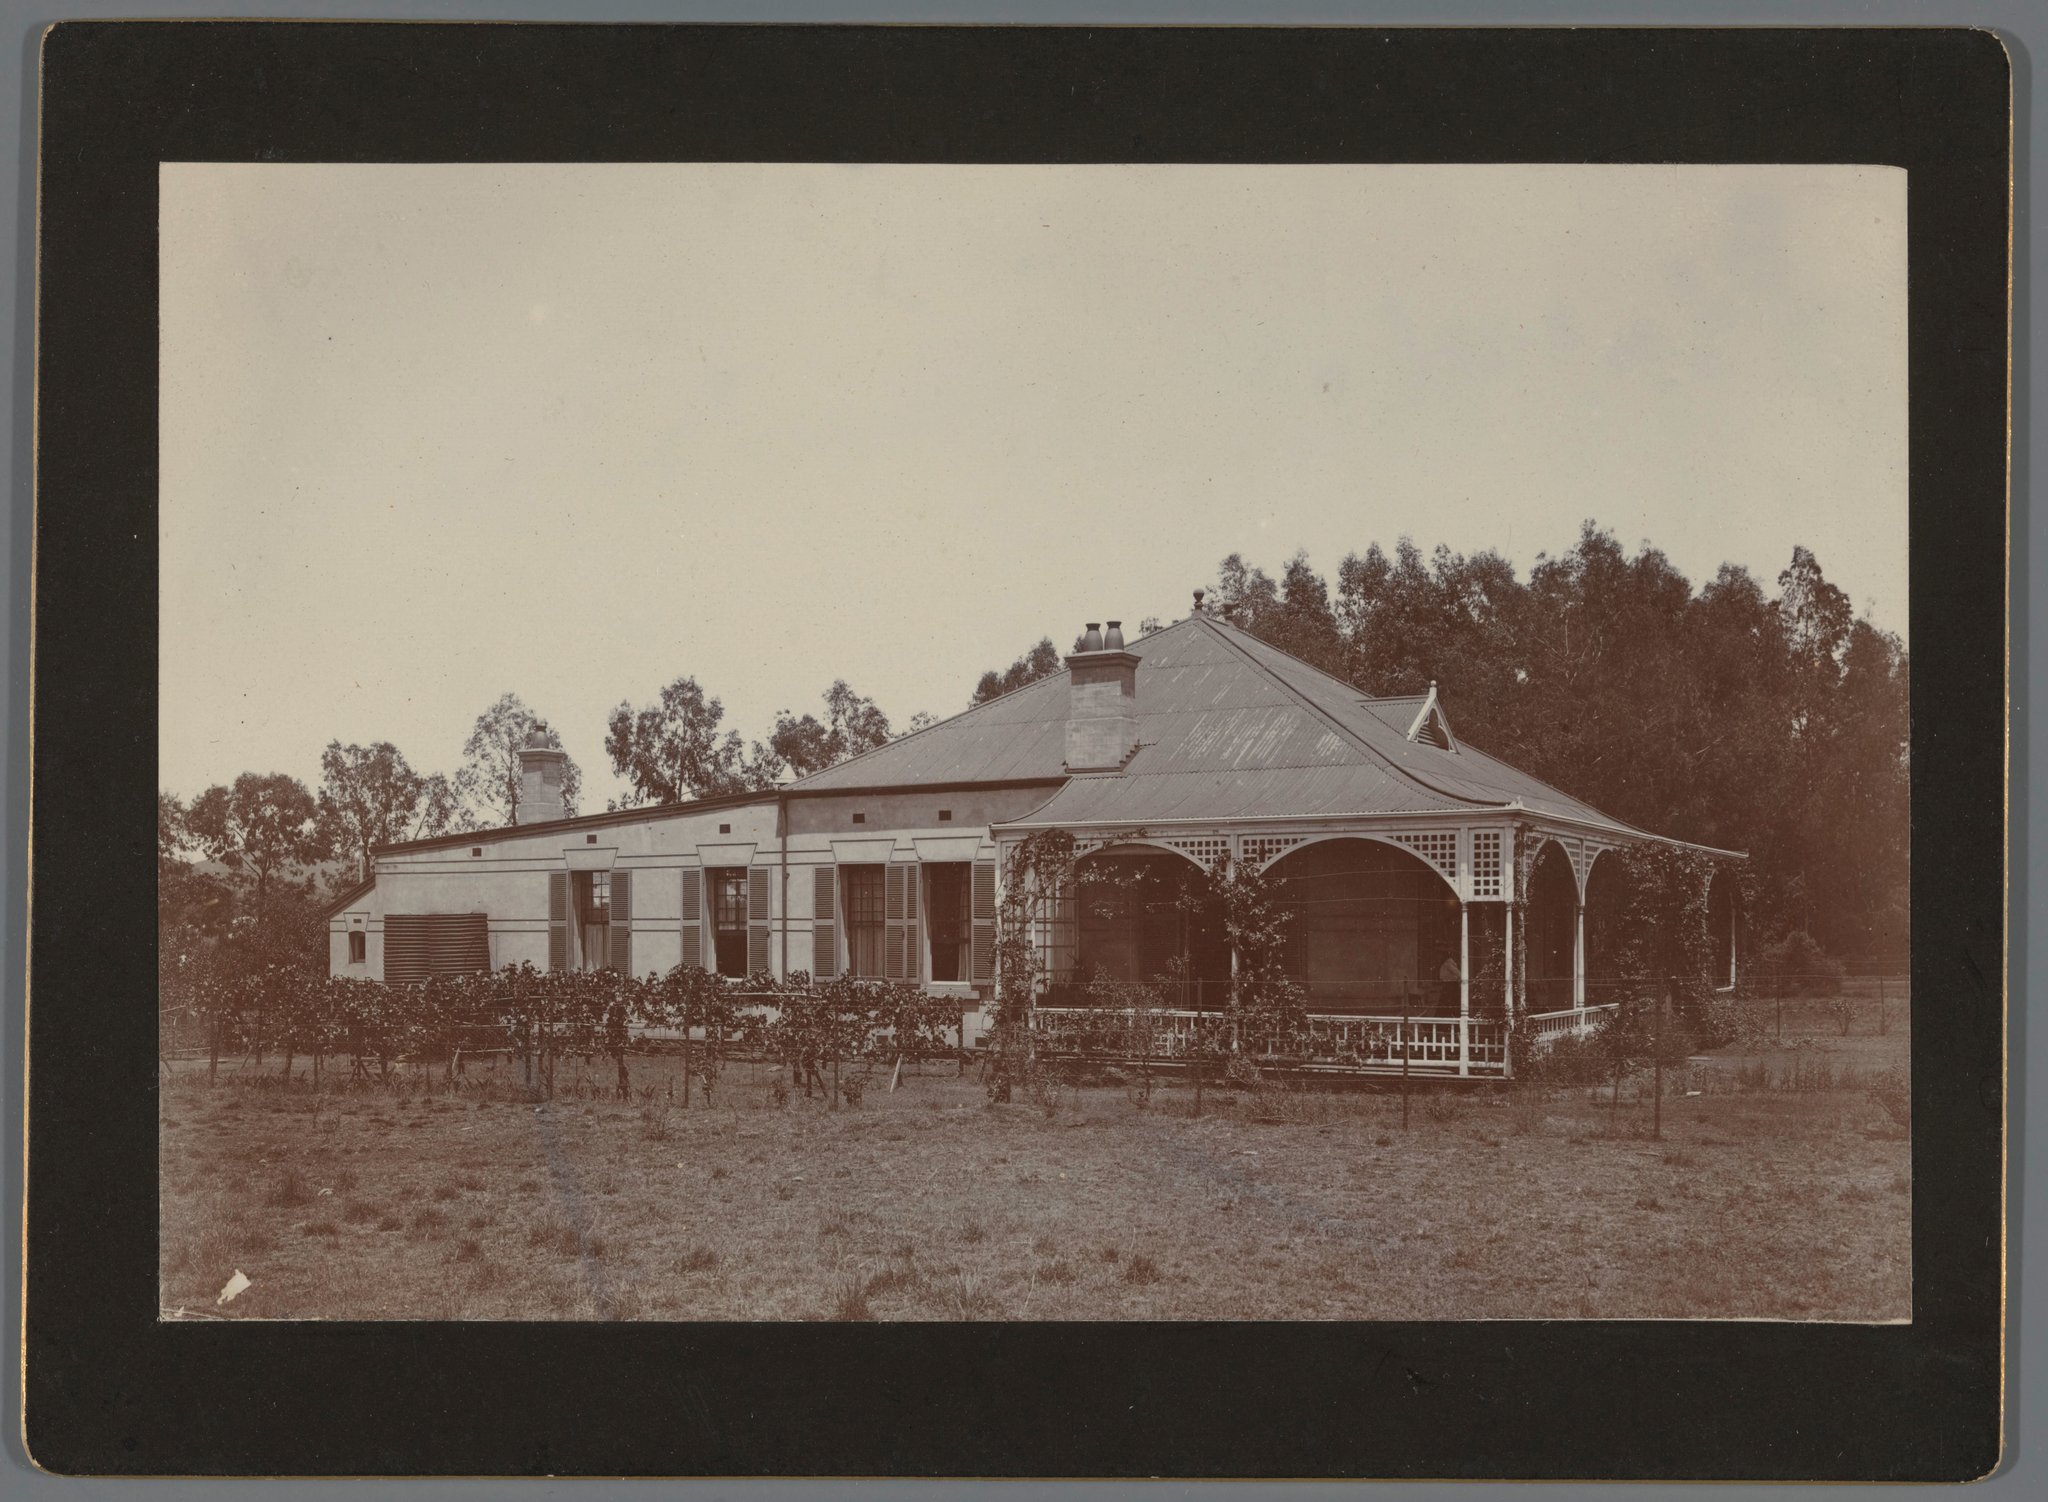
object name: photograph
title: Huis met tuin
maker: cornelia hendrika jonker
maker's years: 1874-1924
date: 1880-1920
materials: cardboard, photographic support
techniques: collodion silver print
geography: south africa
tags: garden, villa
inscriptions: annotation: ‘huis Z-Afrika/ Fokkens-Jonker’